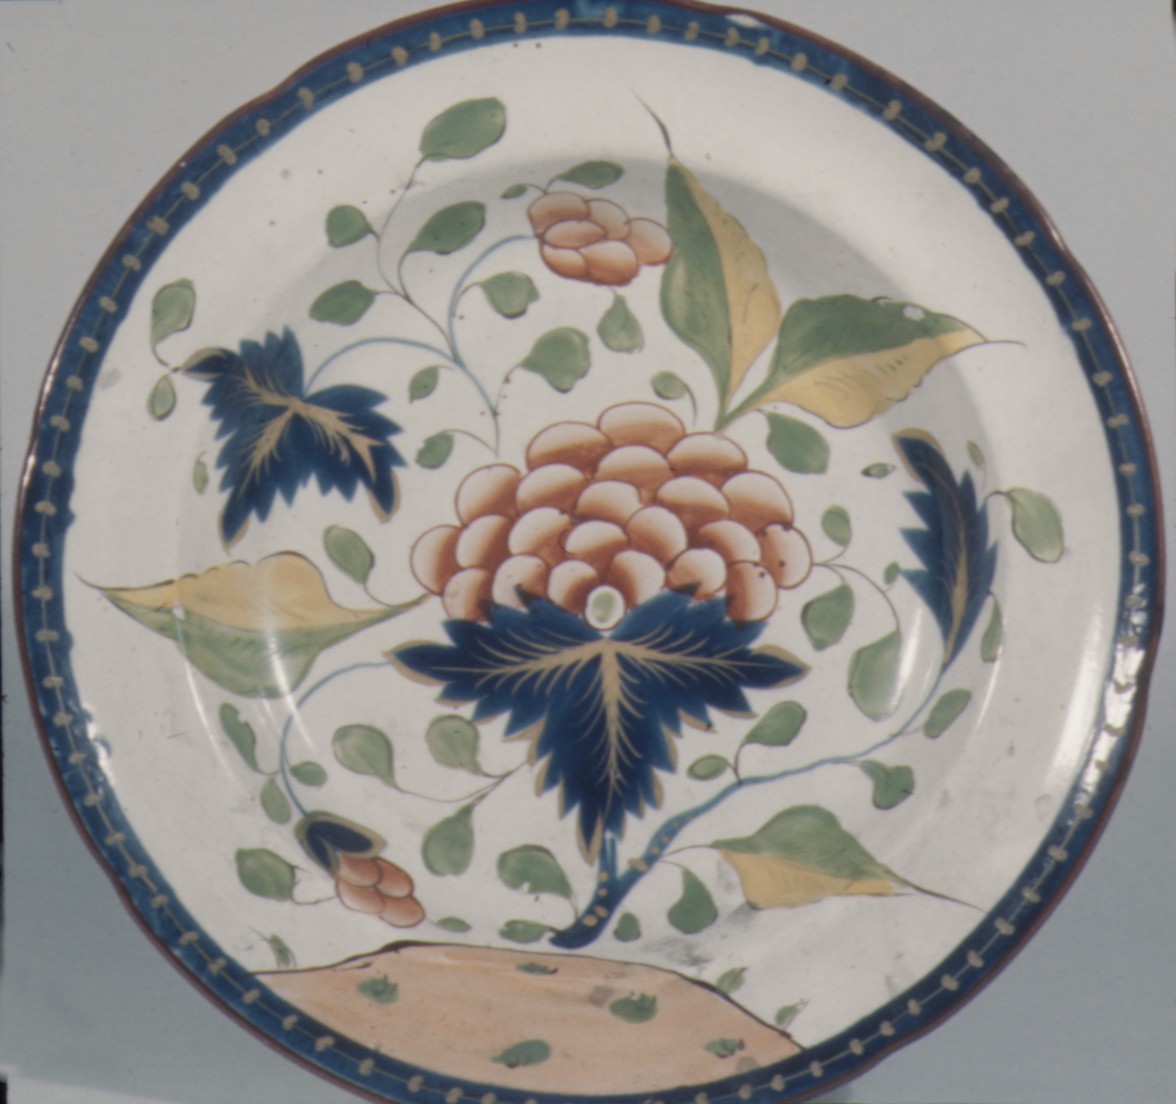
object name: dish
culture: british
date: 1825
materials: earthenware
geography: england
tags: flowers